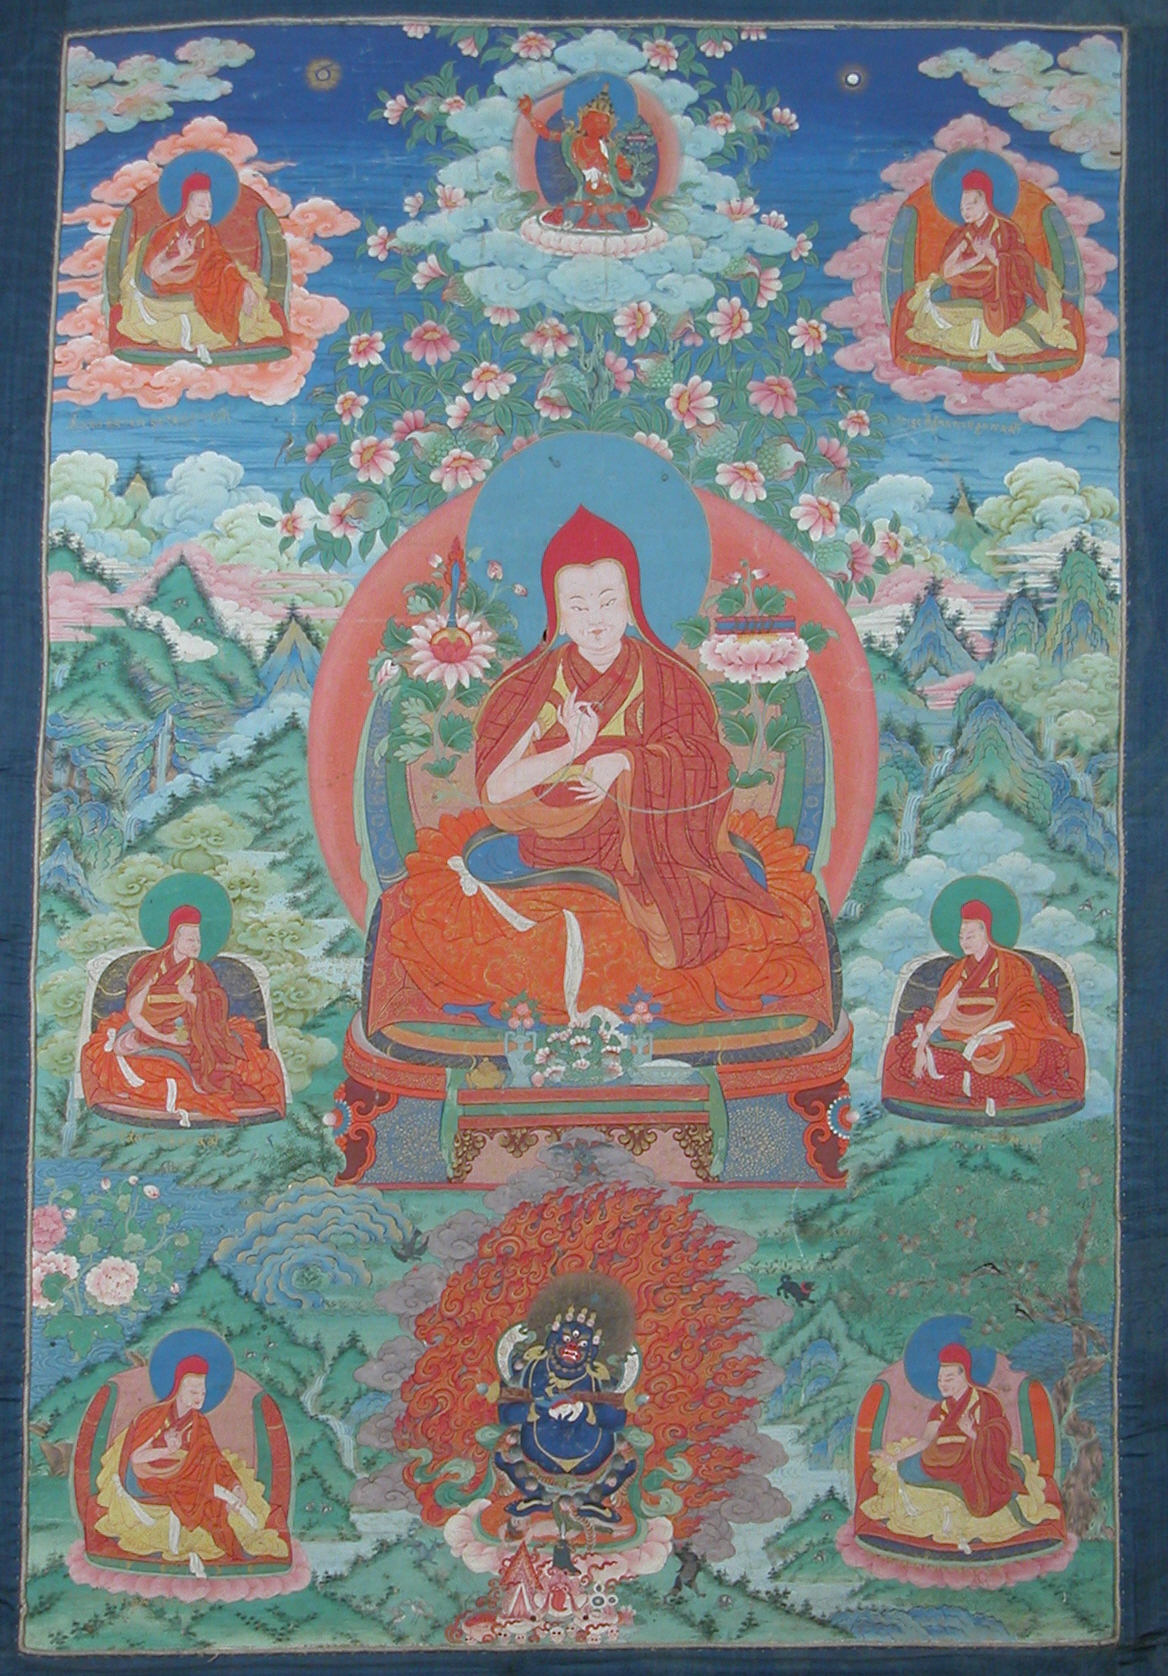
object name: thangka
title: Sakya Pandita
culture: tibet, eastern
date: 1701-1800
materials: textile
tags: men,flowers,buddhism